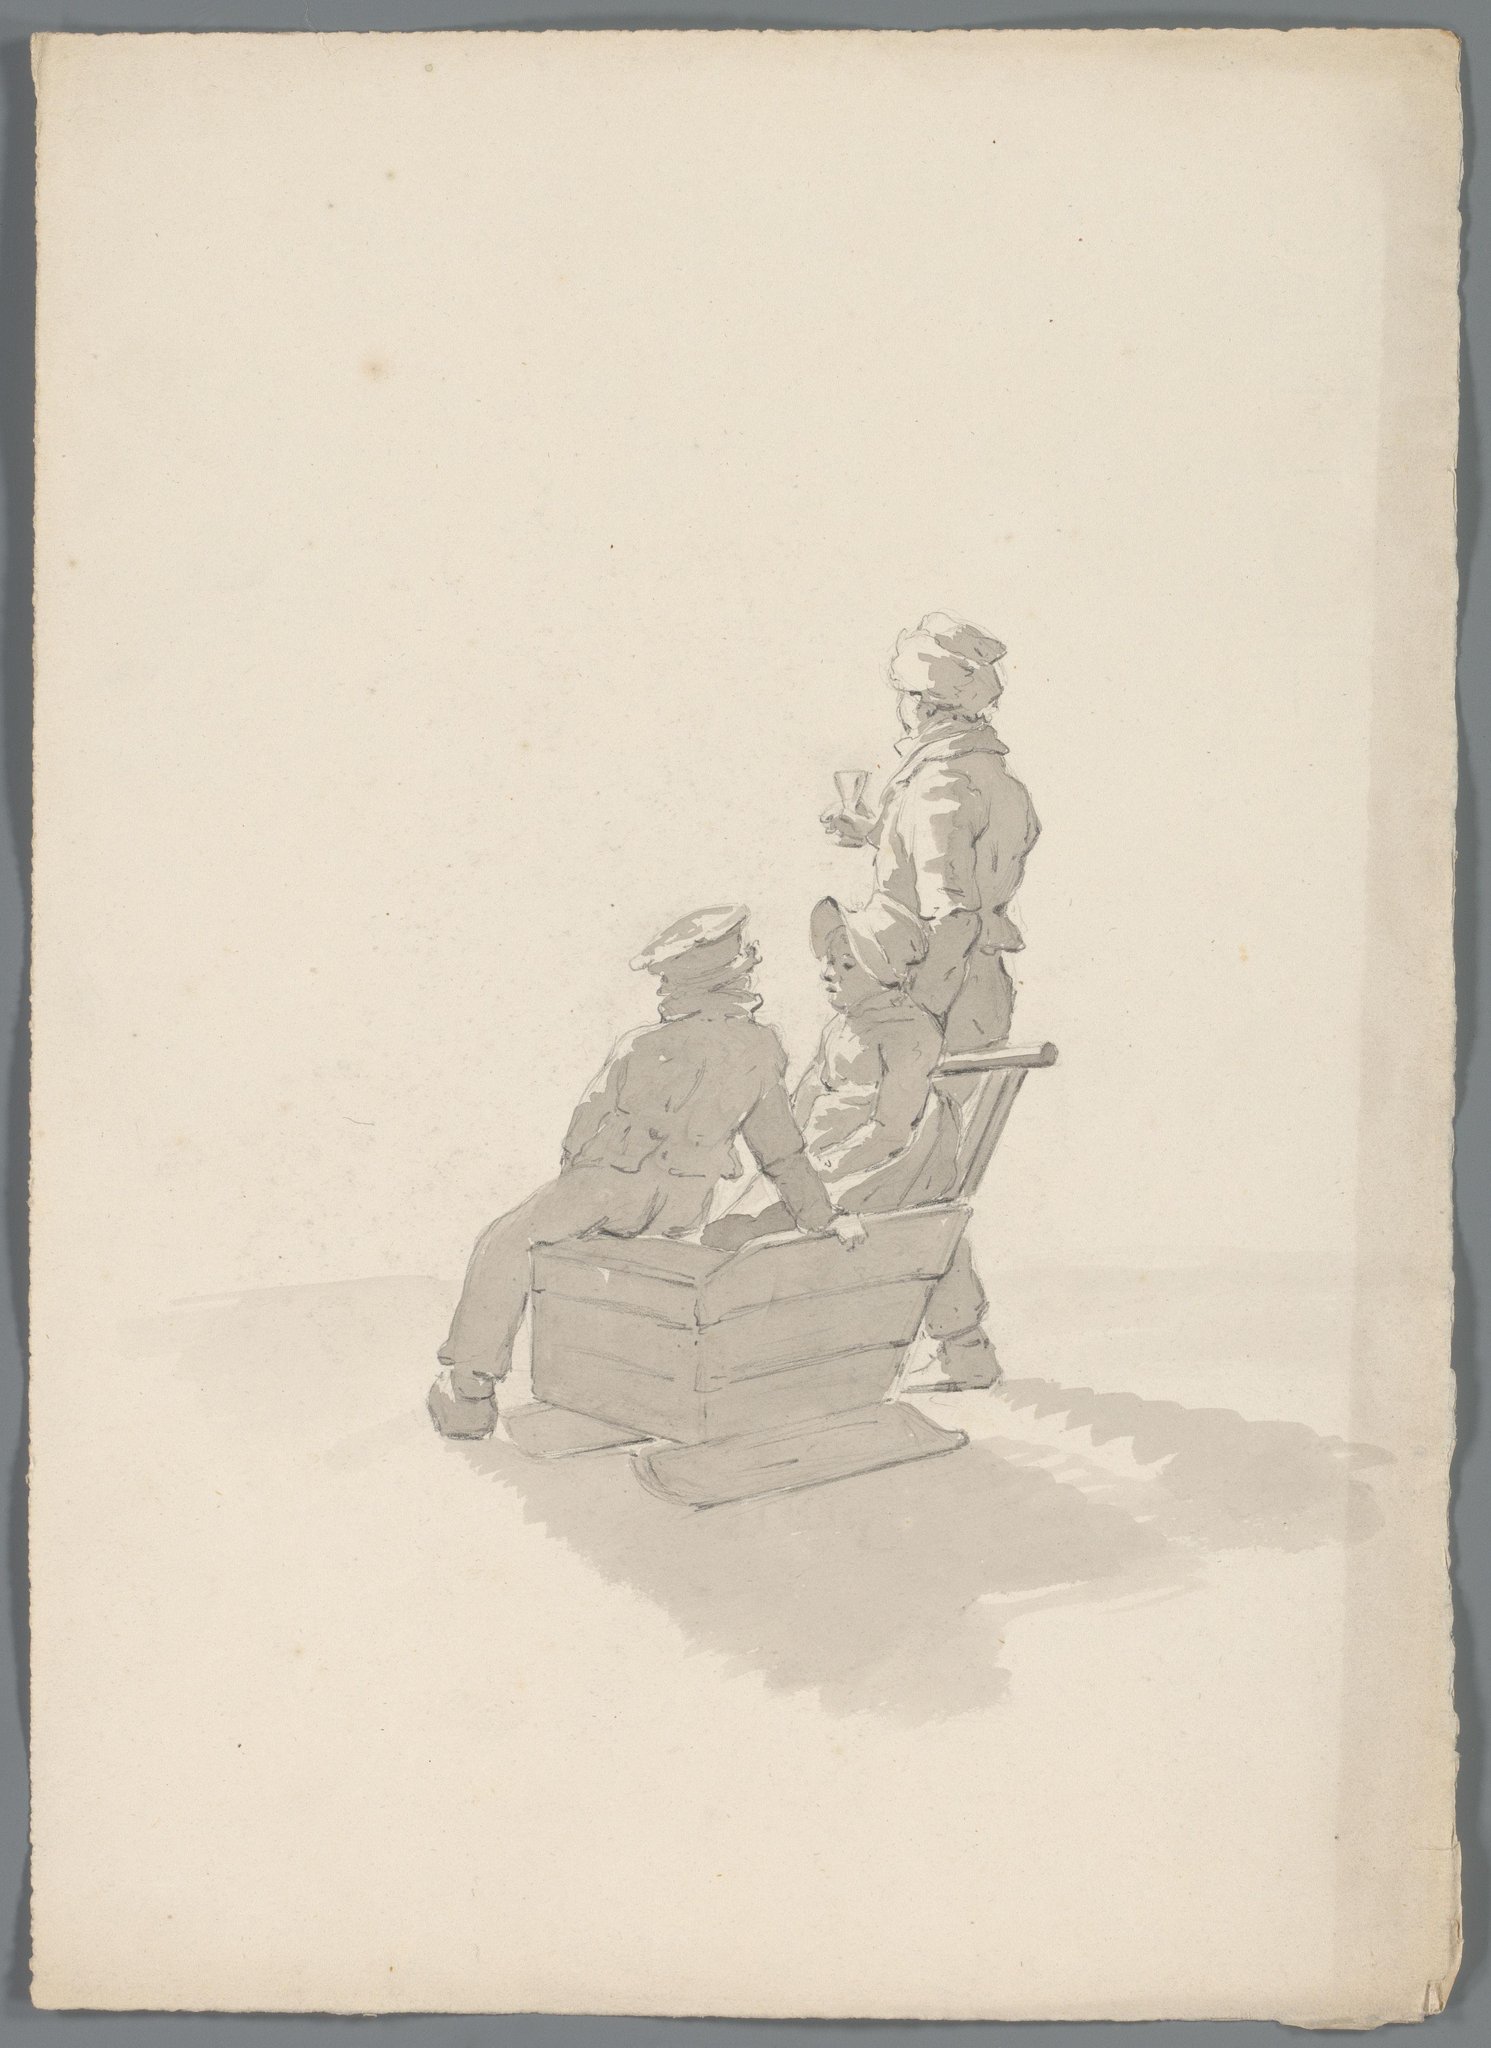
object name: drawing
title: Studie van drie personen, op de rug gezien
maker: Anonymous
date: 1820-1830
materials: chalk, paper, pencil, watercolor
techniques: brush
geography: the hague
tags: non-aggressive relationships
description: Tekeningen waarschijnlijk ontstaan bij het Haagse kunstgenootschap ‘Tot Nut der Tekenkunst’, waar twee keer per week tekenavonden werden georganiseerd met geklede modellen.